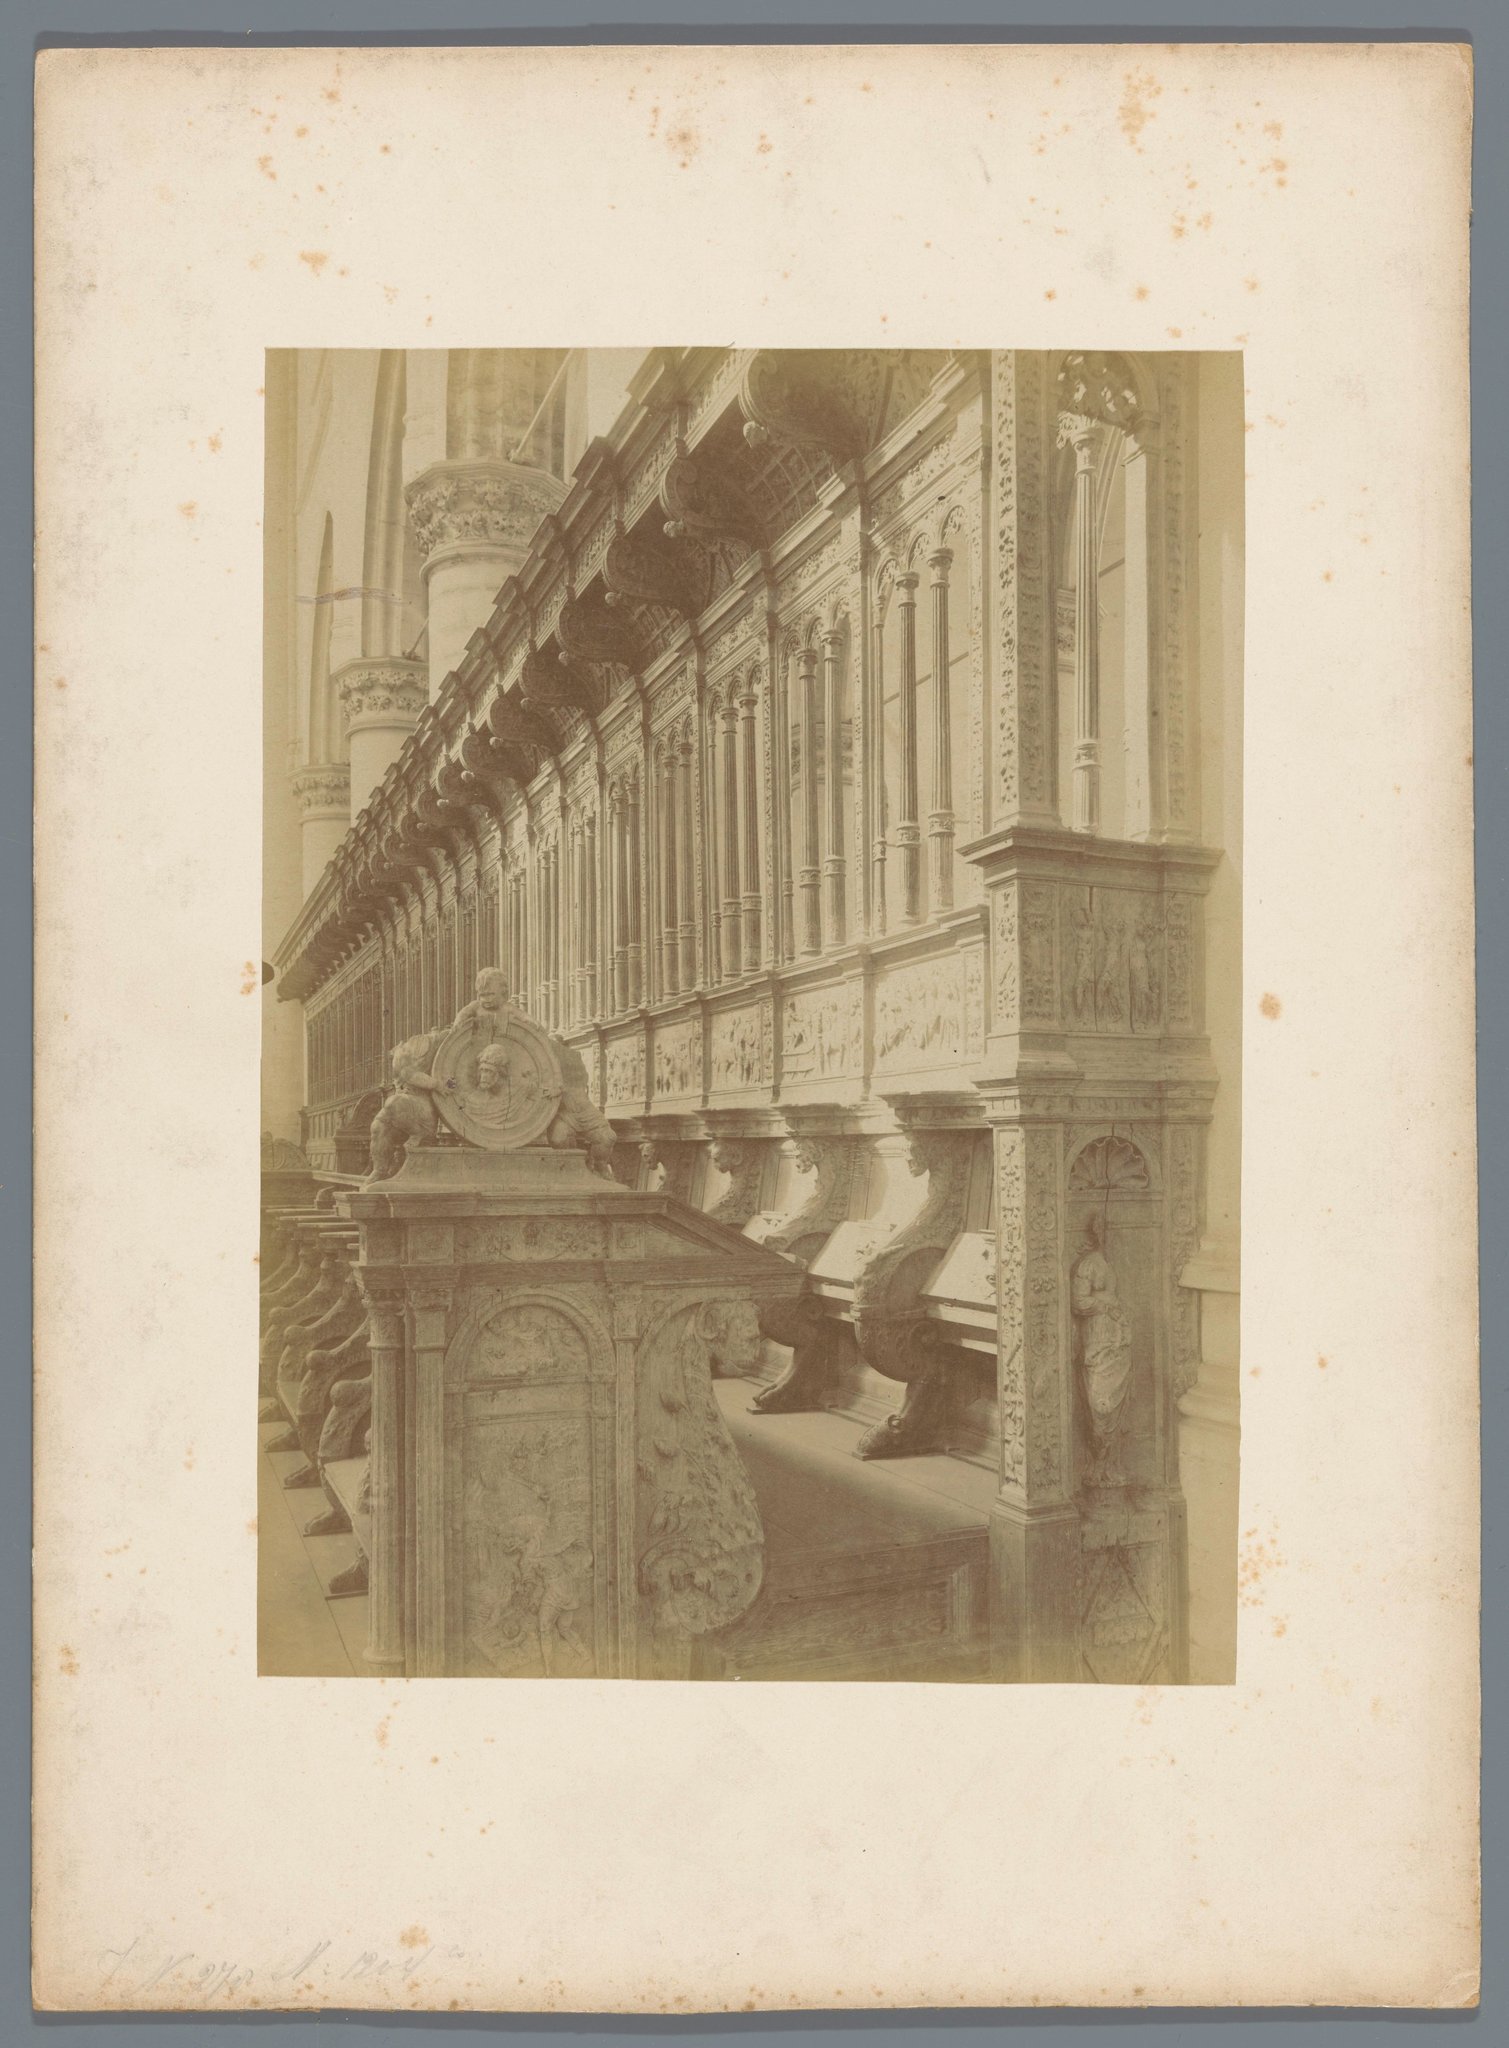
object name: photograph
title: Koorbanken in de Grote Kerk te Dordrecht, gezien vanaf de zijkant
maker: Anonymous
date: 1875-1900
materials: cardboard, photographic support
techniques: albumen print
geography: grote of onze-lieve-vrouwekerk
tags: interior of church, seats of the clergy, choir-stalls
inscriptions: inscription: ‘neg. no 14468 foto no 6684’, annotation, inscription: ‘Dordrecht. Z. H. Ned. Herv. Kerk Choorbanken.’